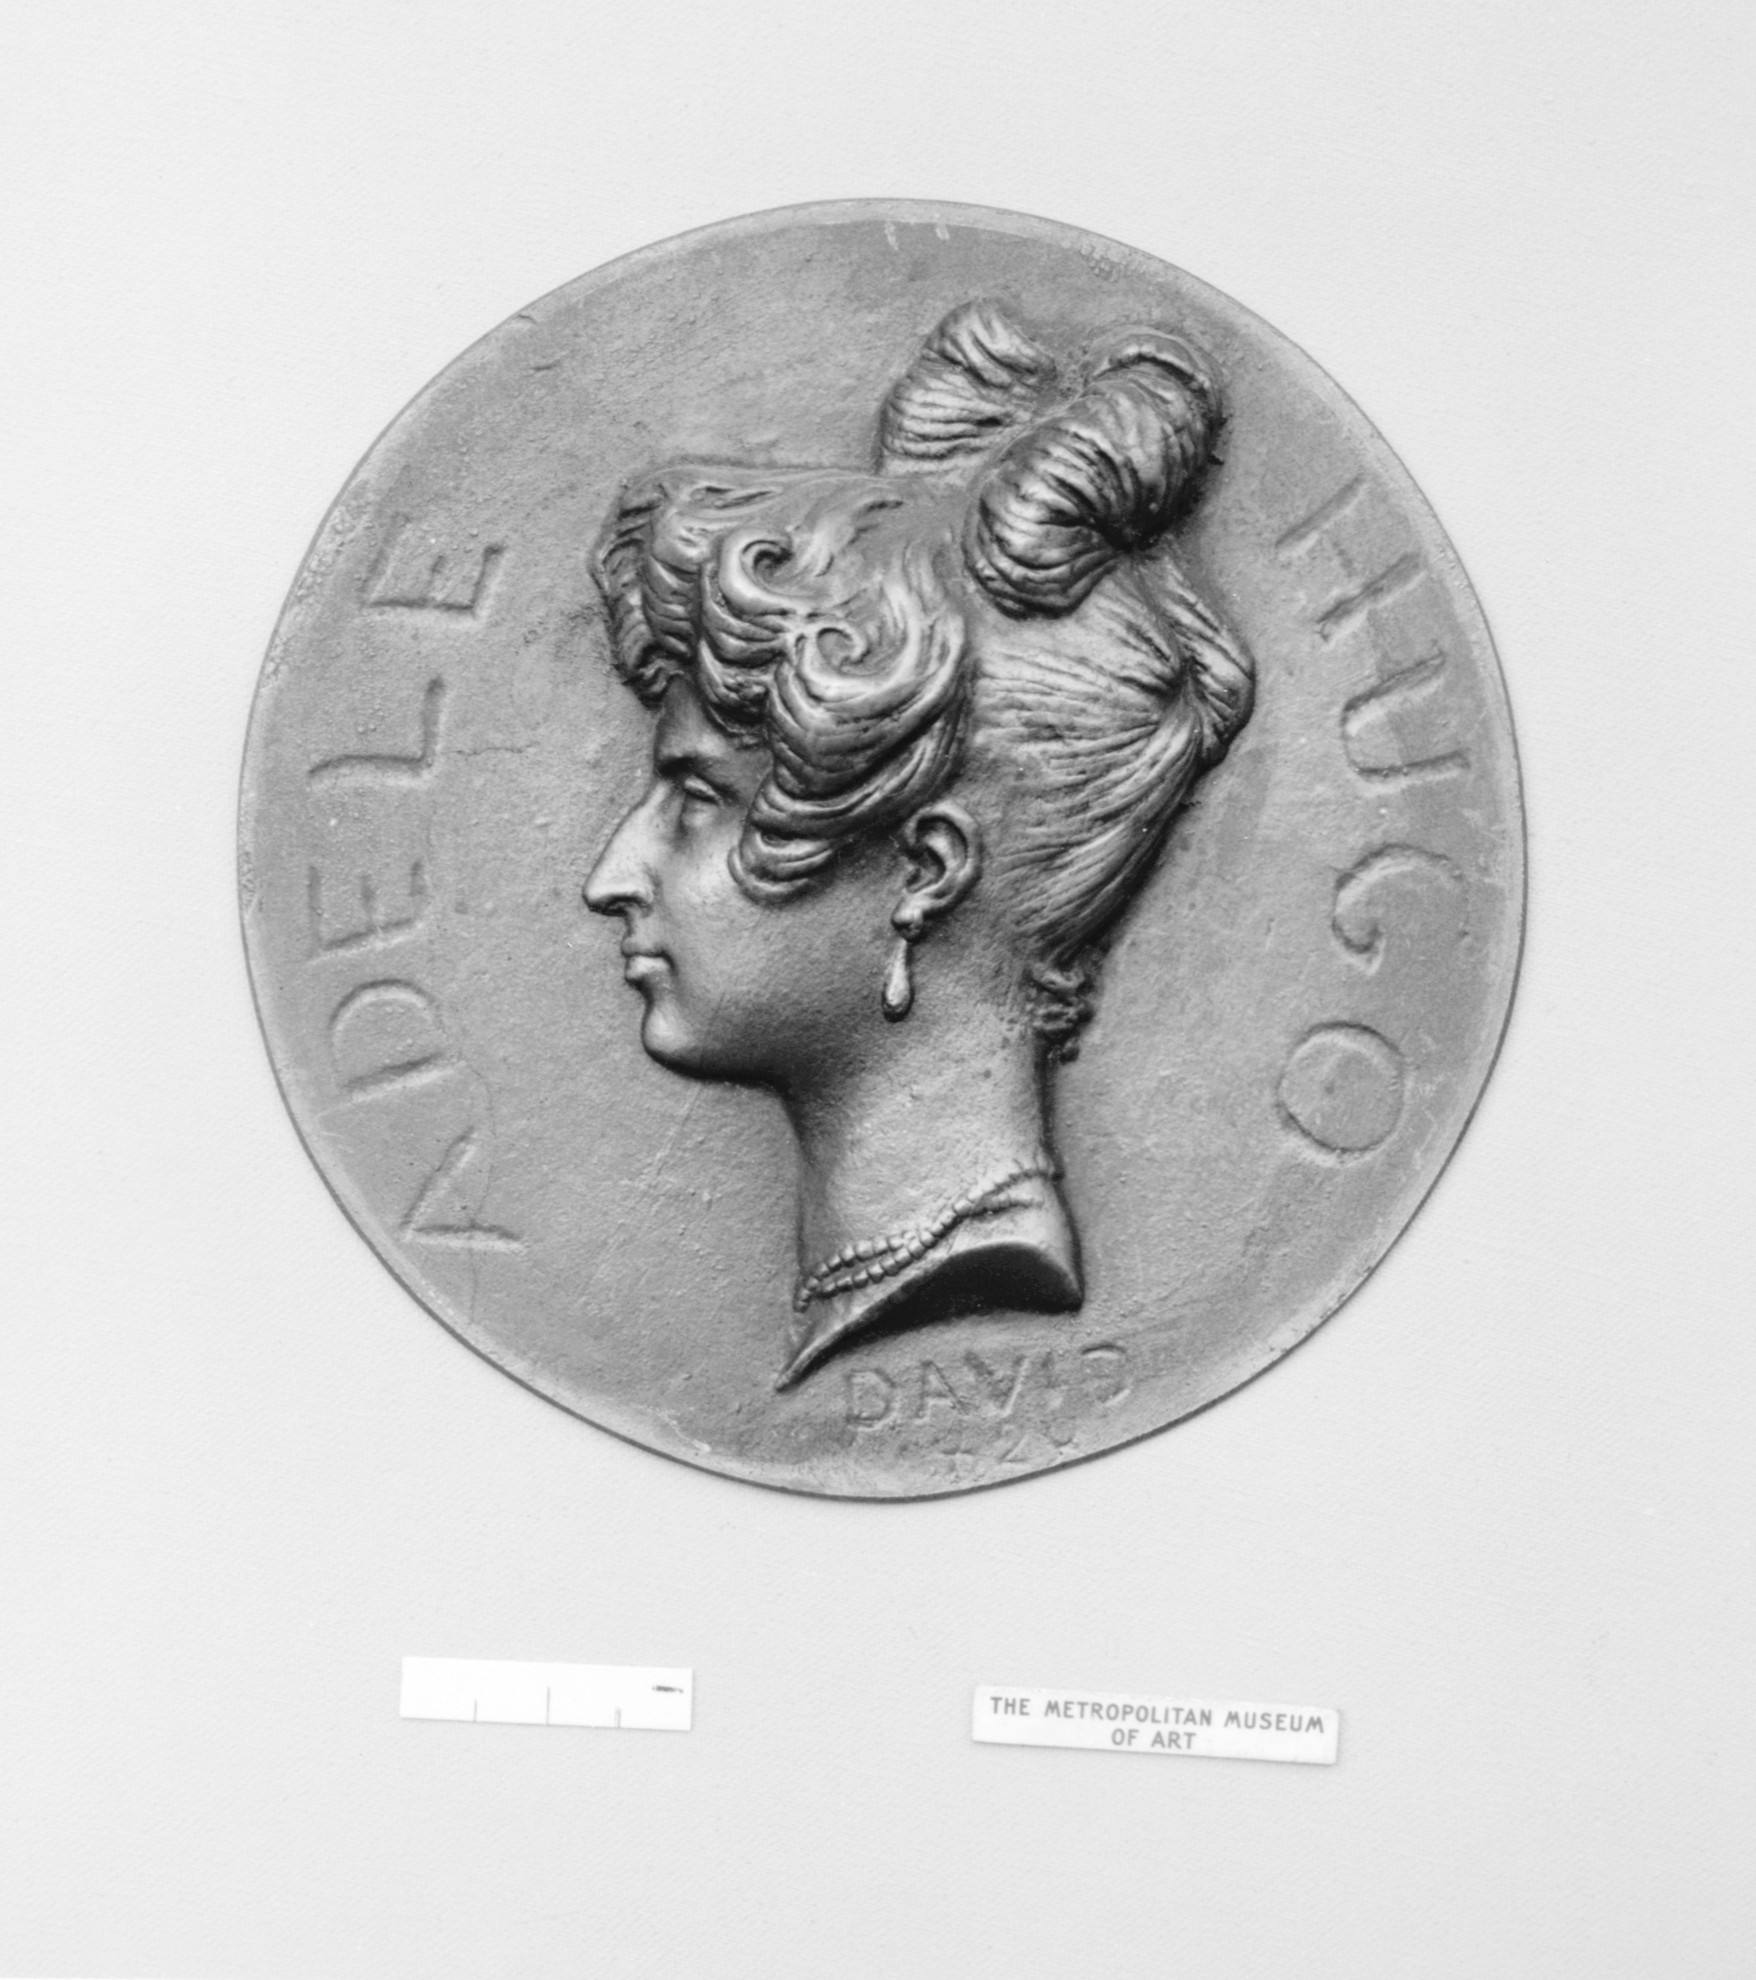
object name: medallion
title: Adèle Hugo (née Foucher, wife of Victor Hugo) (d. 1868)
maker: pierre jean david d'angers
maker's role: artist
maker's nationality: french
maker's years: 1788-1856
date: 1828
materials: bronze, patina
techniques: casting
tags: profiles,women